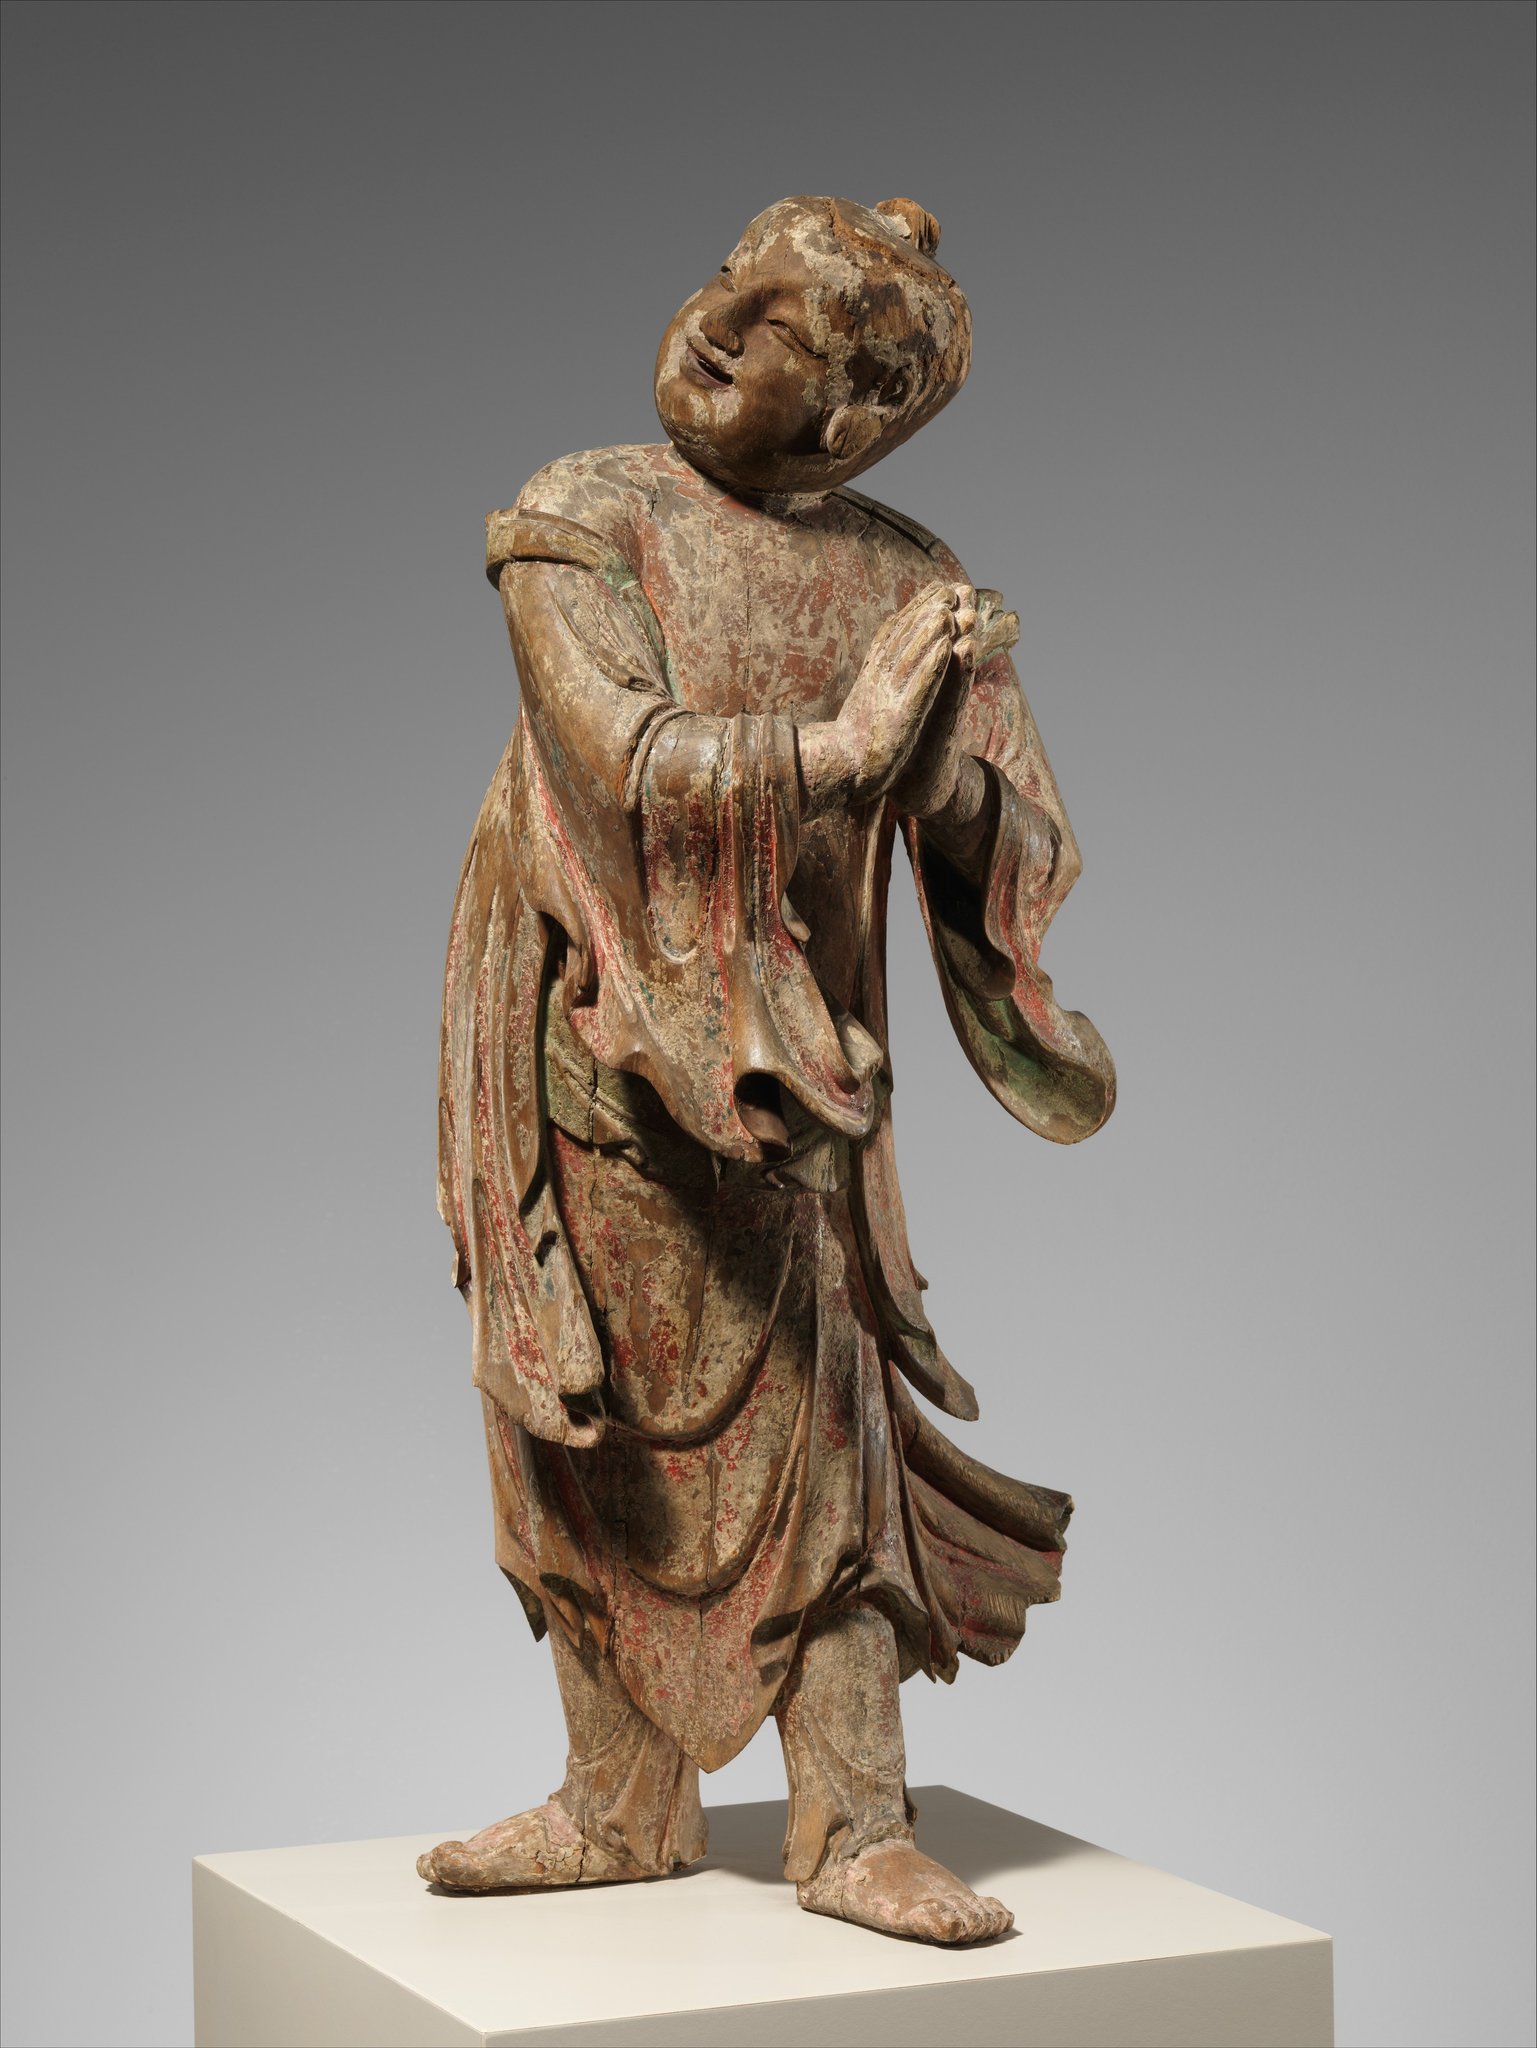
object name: figure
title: Pilgrim Sudhana (Shancai tongzi)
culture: chinese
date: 1467-1633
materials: pigment, wood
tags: boys